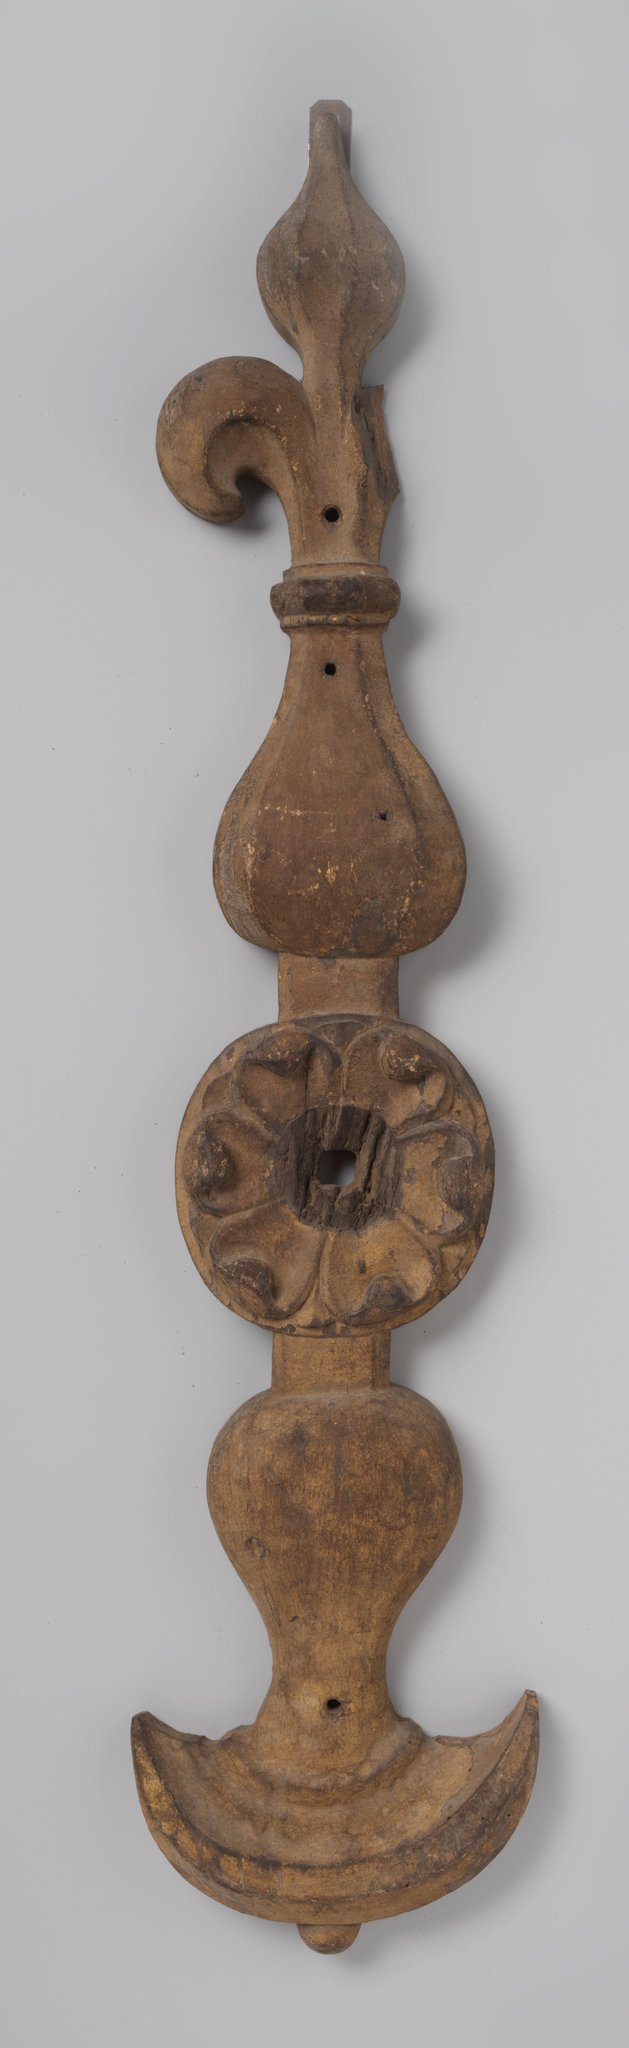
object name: horlogewijzer, wijzer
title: Wijzer afkomstig van het uurwerk in de stadstoren te Middelburg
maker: Anonymous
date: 1600-1699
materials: wood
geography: netherlands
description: Wijzer afkomstig van het uurwerk in de stadstoren te Middelburg. Deels oud, deels van latere datum. Resten van goudverf, een deel is afgebroken.